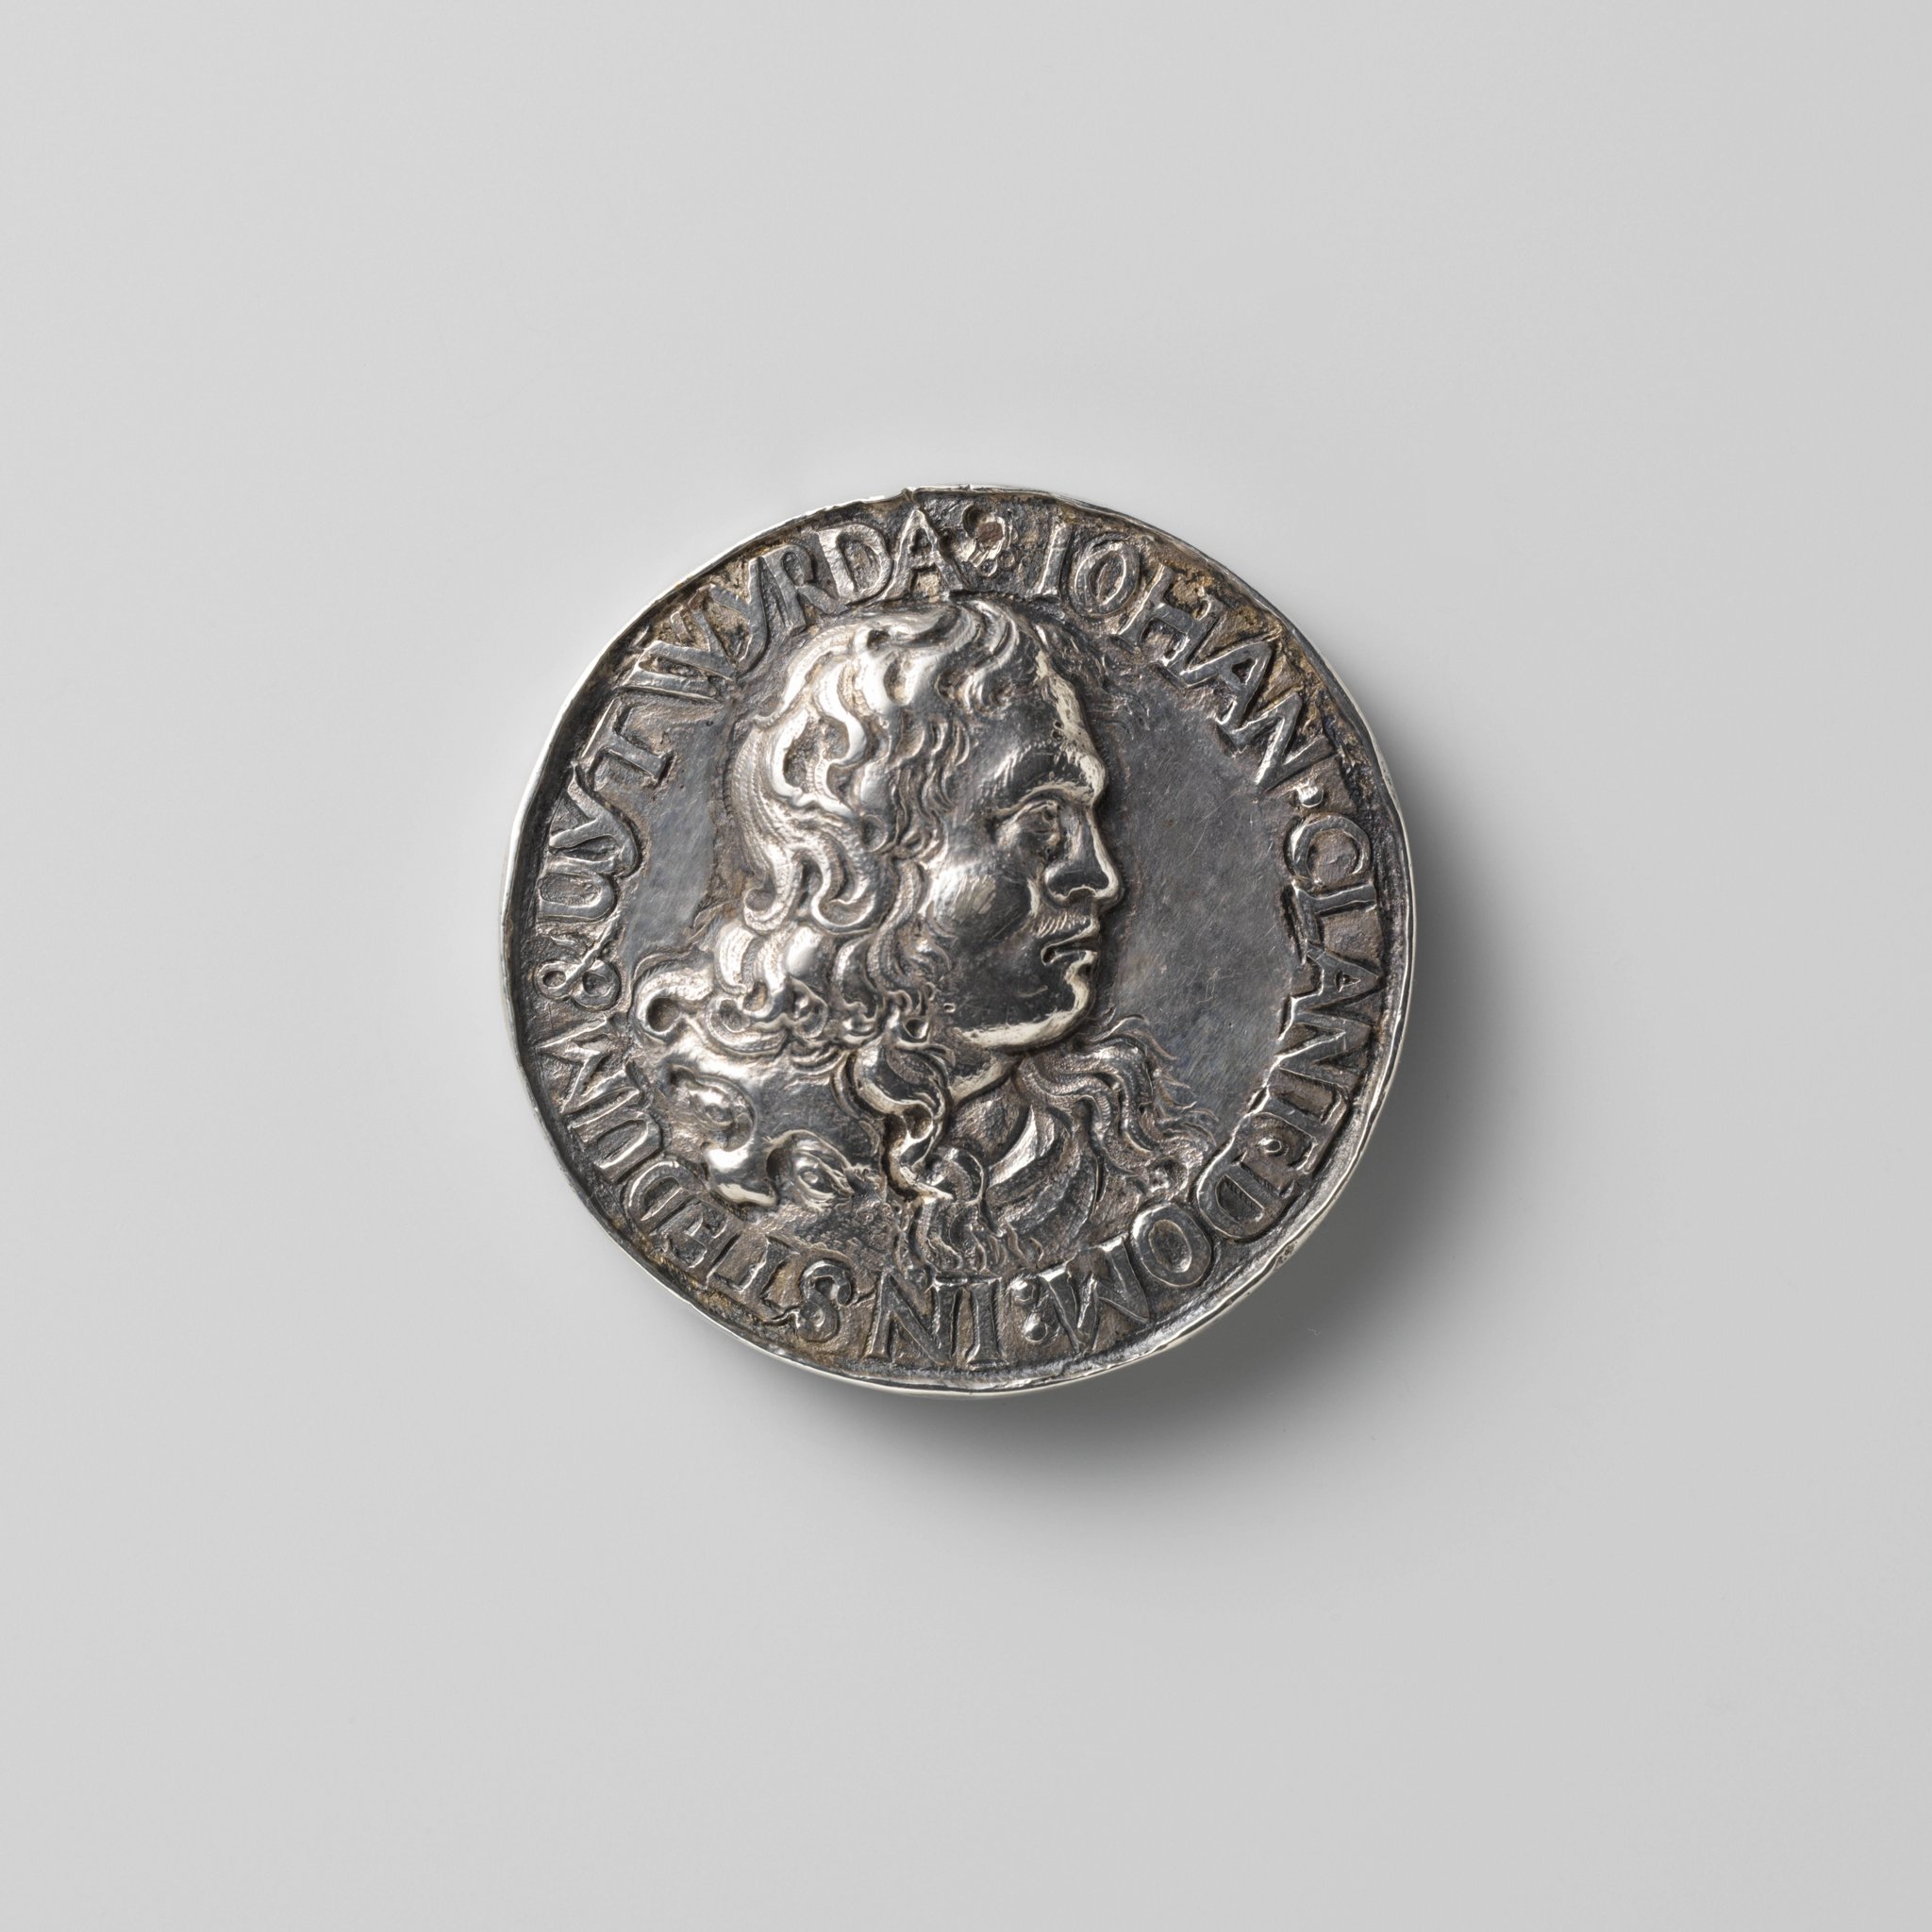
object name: medal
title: Johan Clant, Lords of Stedum and Uitwierda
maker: Anonymous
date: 1693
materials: silver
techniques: casting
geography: low countries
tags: groningen (province)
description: Johan Clant (1624-1694) is de zoon van Adriaan Clant en Hille Clant en was landjonker in Groningen. Hij trouwde op 17 december 1653 te Groningen met Anna Coenders. Het echtpaar kreeg vier dochters, Elisabeth, Helena, Gesina en Willemine. Vader Adriaan Clant vertegenwoordigde in 1648 Stad en Lande (=Groningen) tijdens de vredesonderhandelimngen in Munster tussen de Republiek en Spanje. Na diens dood in 1665 richtte Johan voor zijn vader in de kerk van Stedum een grafmonument op, ontworpen door Rombout Verhulst en voltooid in 1672. Sinds 1658 bekleedde hij de functie van Schepper van de Noordzijde van Appingedam. Zijn woning, Borg Nittersum bij Stedum, liet hij in 1669 volgens een ontwerp van Philips Vingboons verbouwen. Aan de achterzijde van de graftombe van zijn vader in de kerk van Stedum is het wapenbord van Johan aangebracht.